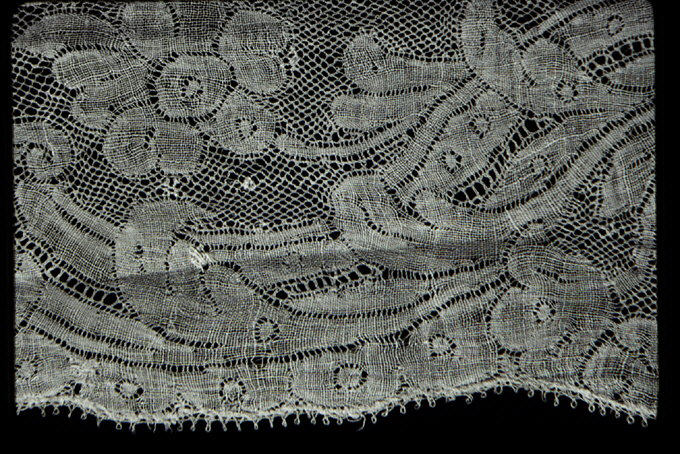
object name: strip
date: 1701-1800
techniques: lace